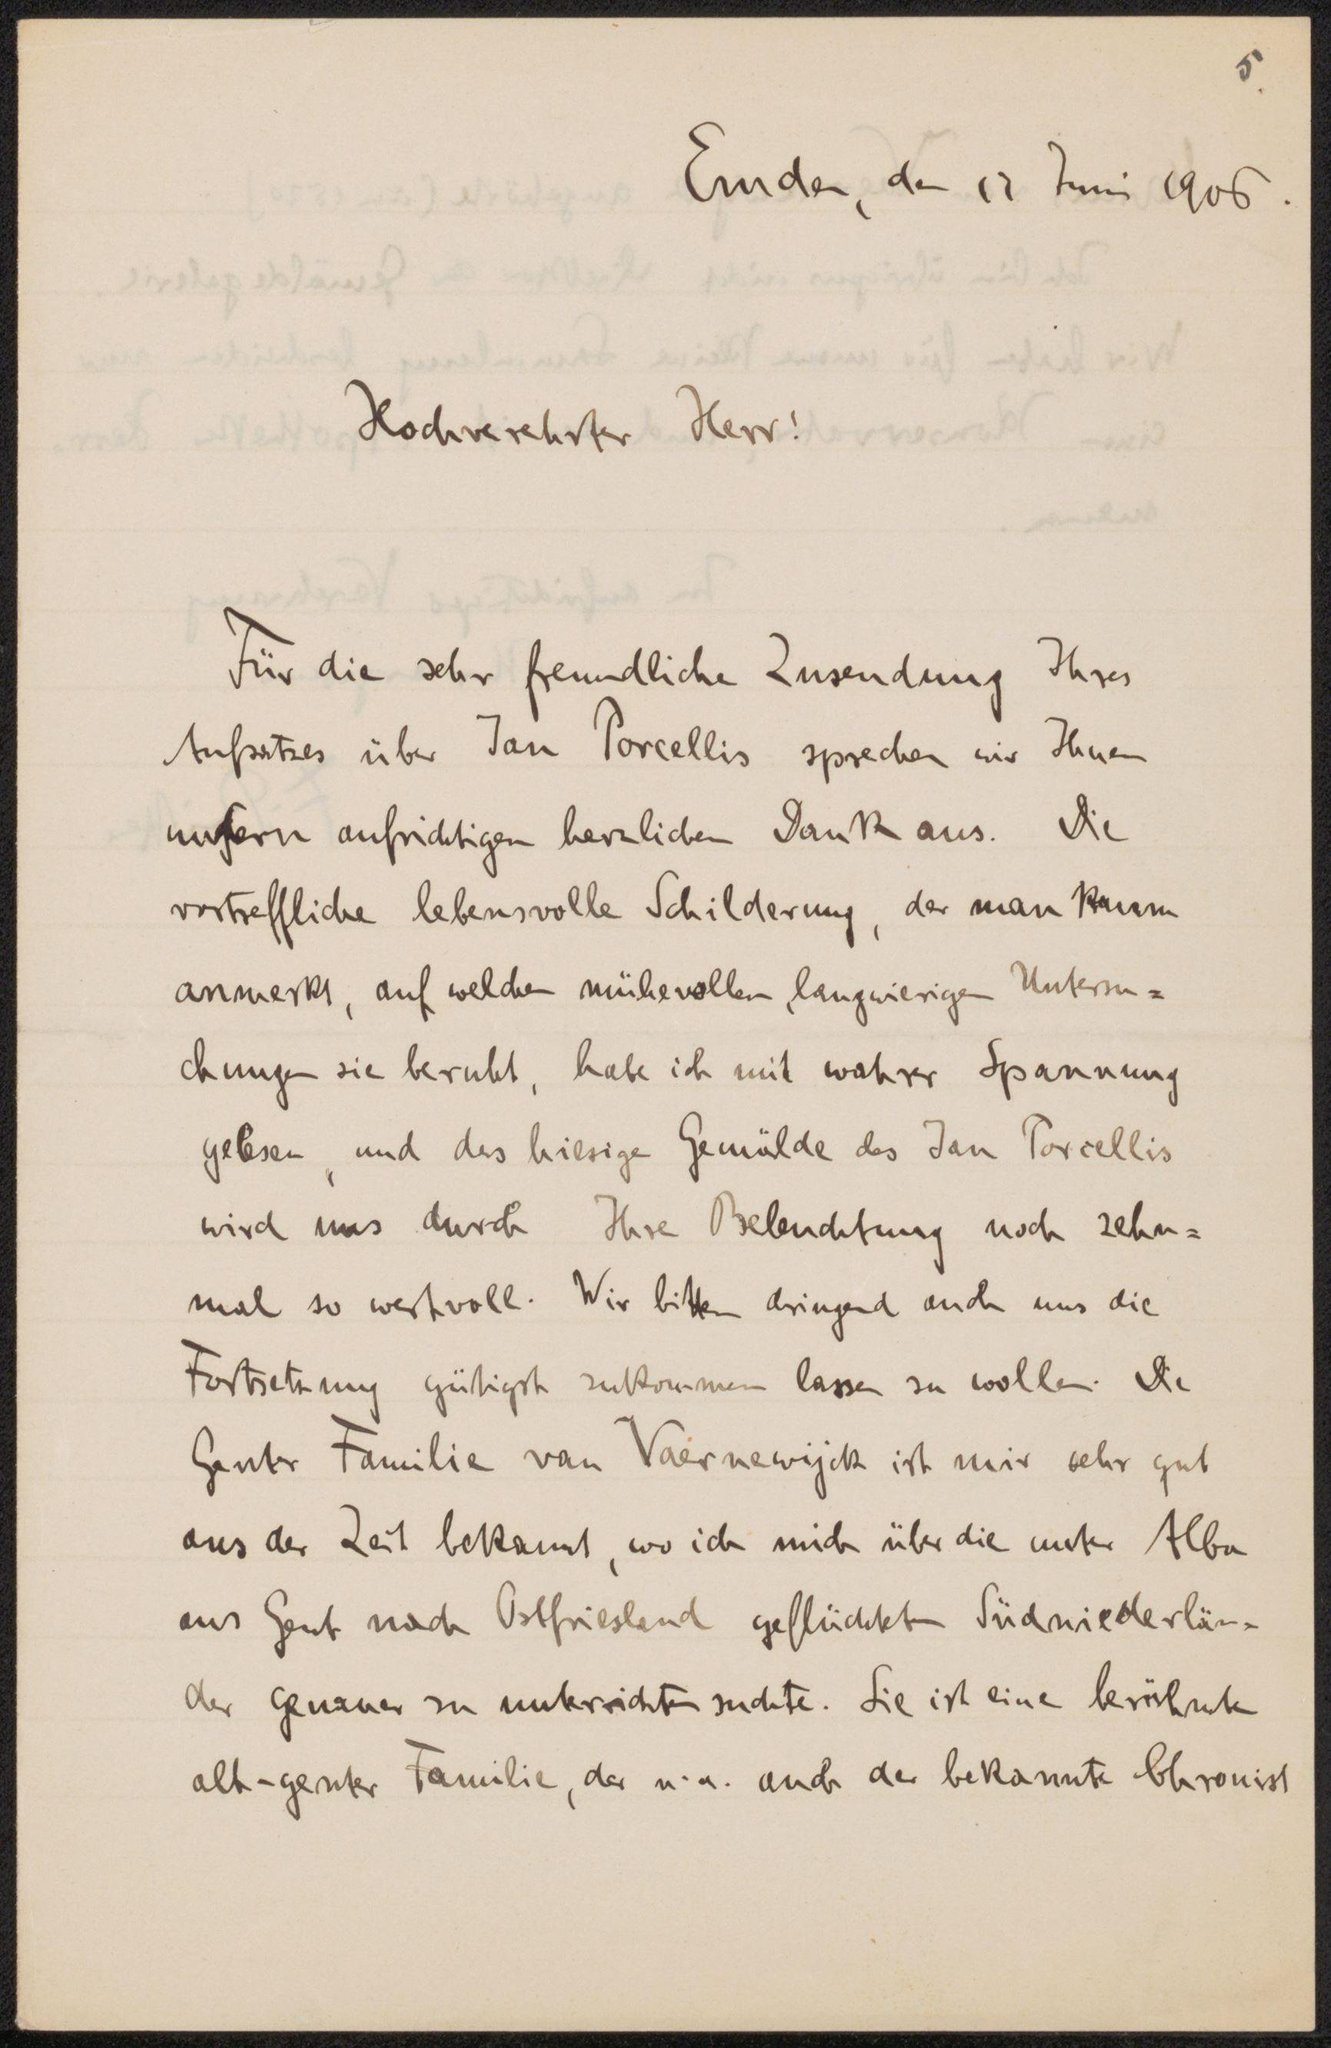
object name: letter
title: Brief aan Pieter Haverkorn van Rijsewijk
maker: f. ritter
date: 1906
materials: ink, paper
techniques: pen, writing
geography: emden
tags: pieter haverkorn van rijsewijk, ghent, painter, print maker, draughtsman, jan porcellis, painting (including book-illumination, miniature-painting)